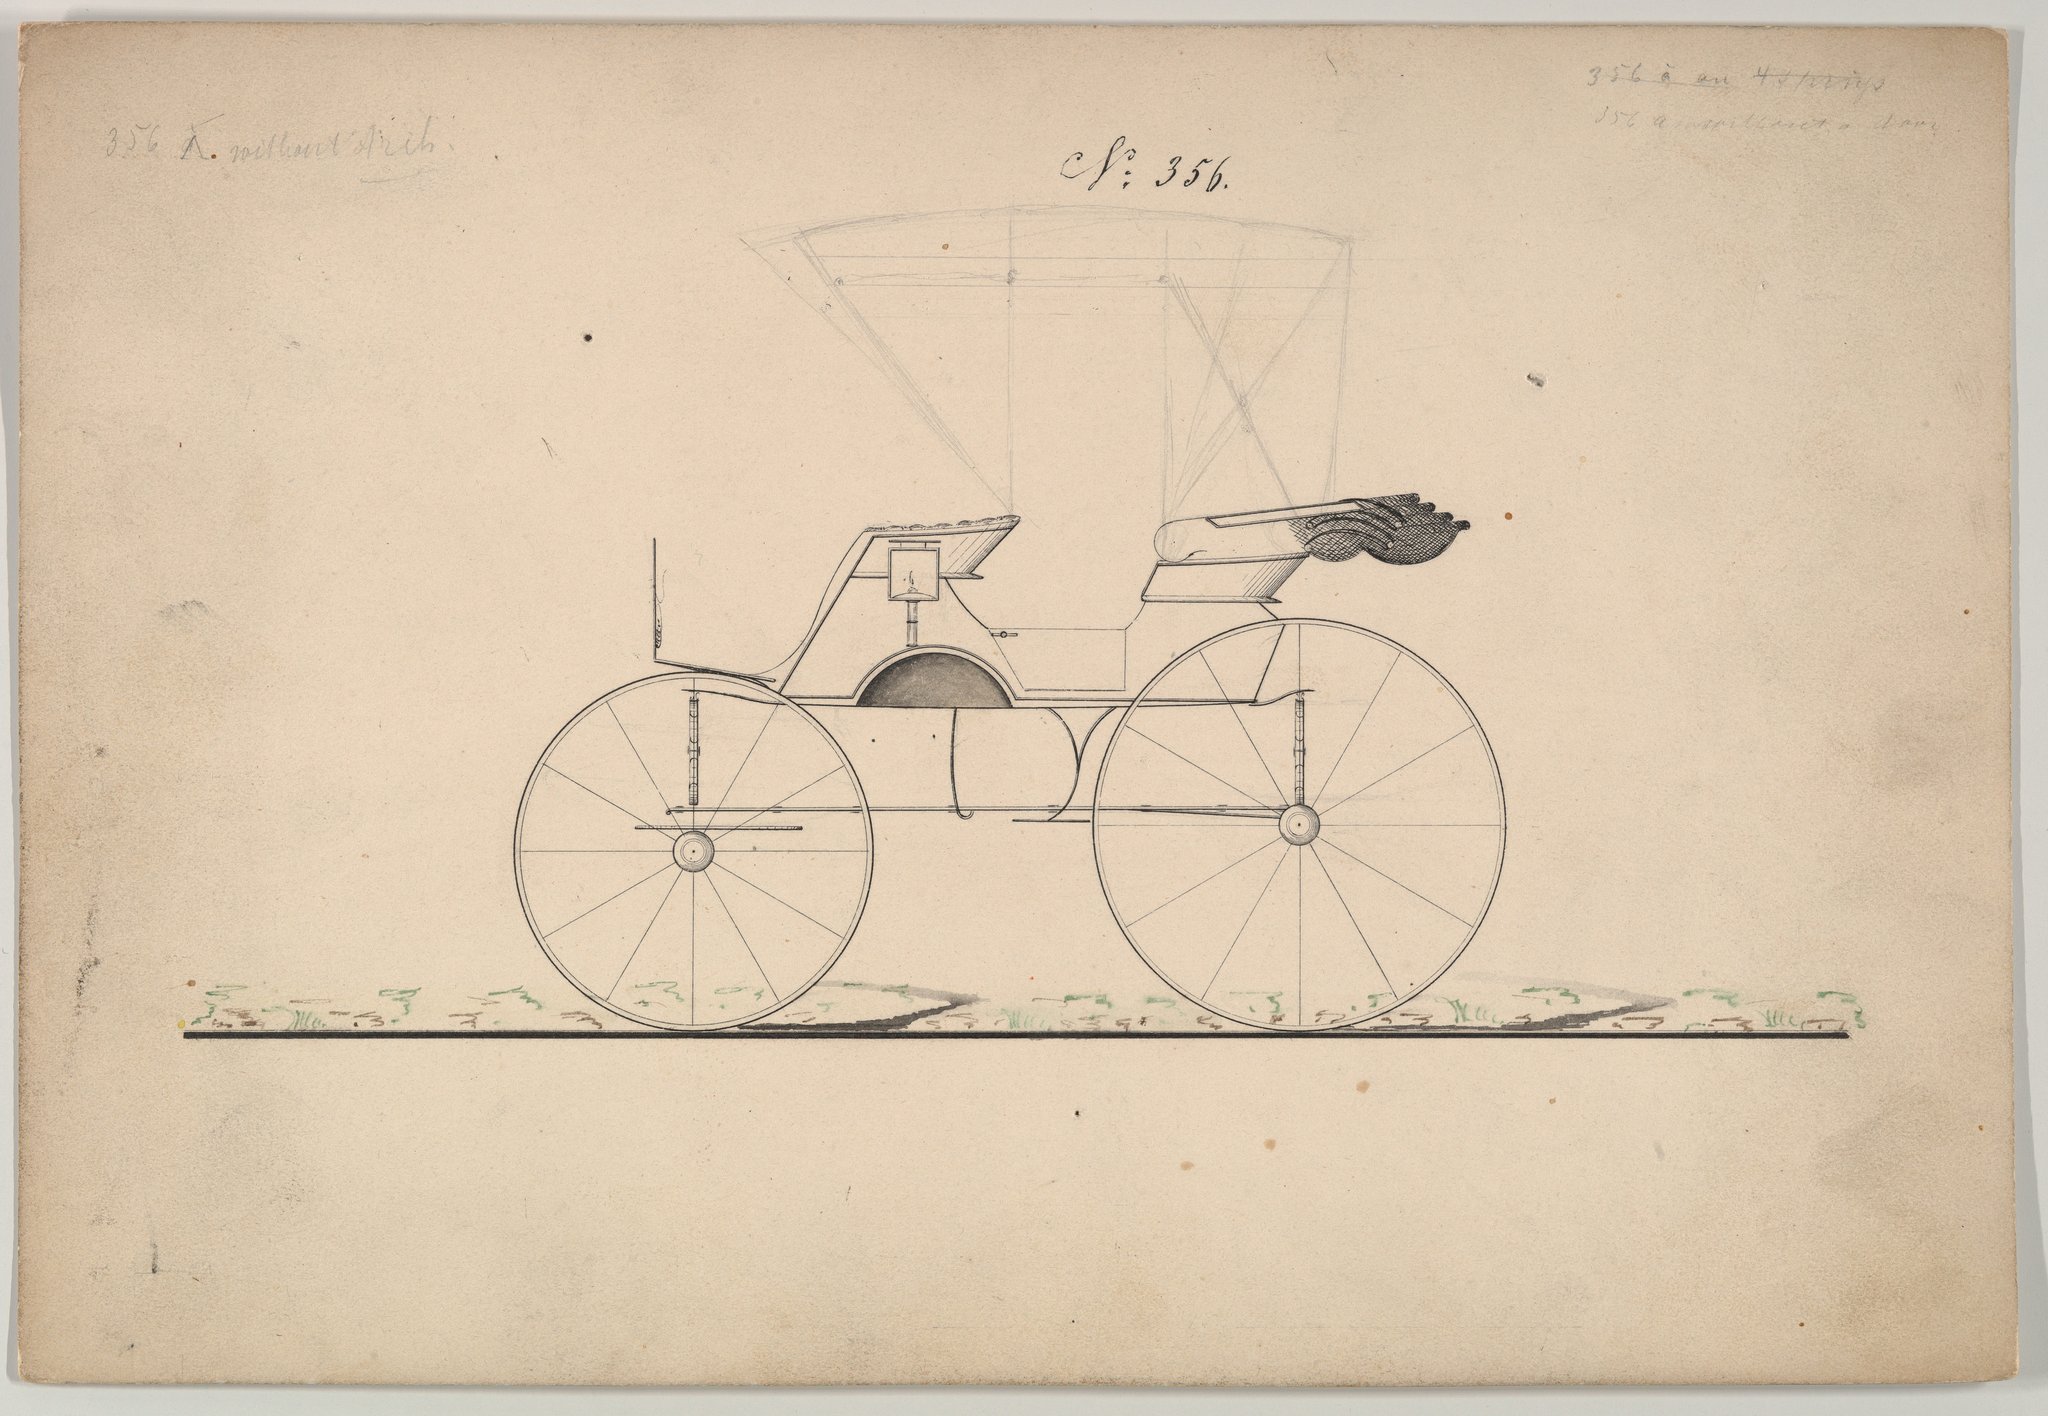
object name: drawing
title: Design for Phaeton, no. 356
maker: brewster & co.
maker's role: manufacturer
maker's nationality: american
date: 1850-1874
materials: gouache, graphite, ink, watercolor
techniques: pen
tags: carriages